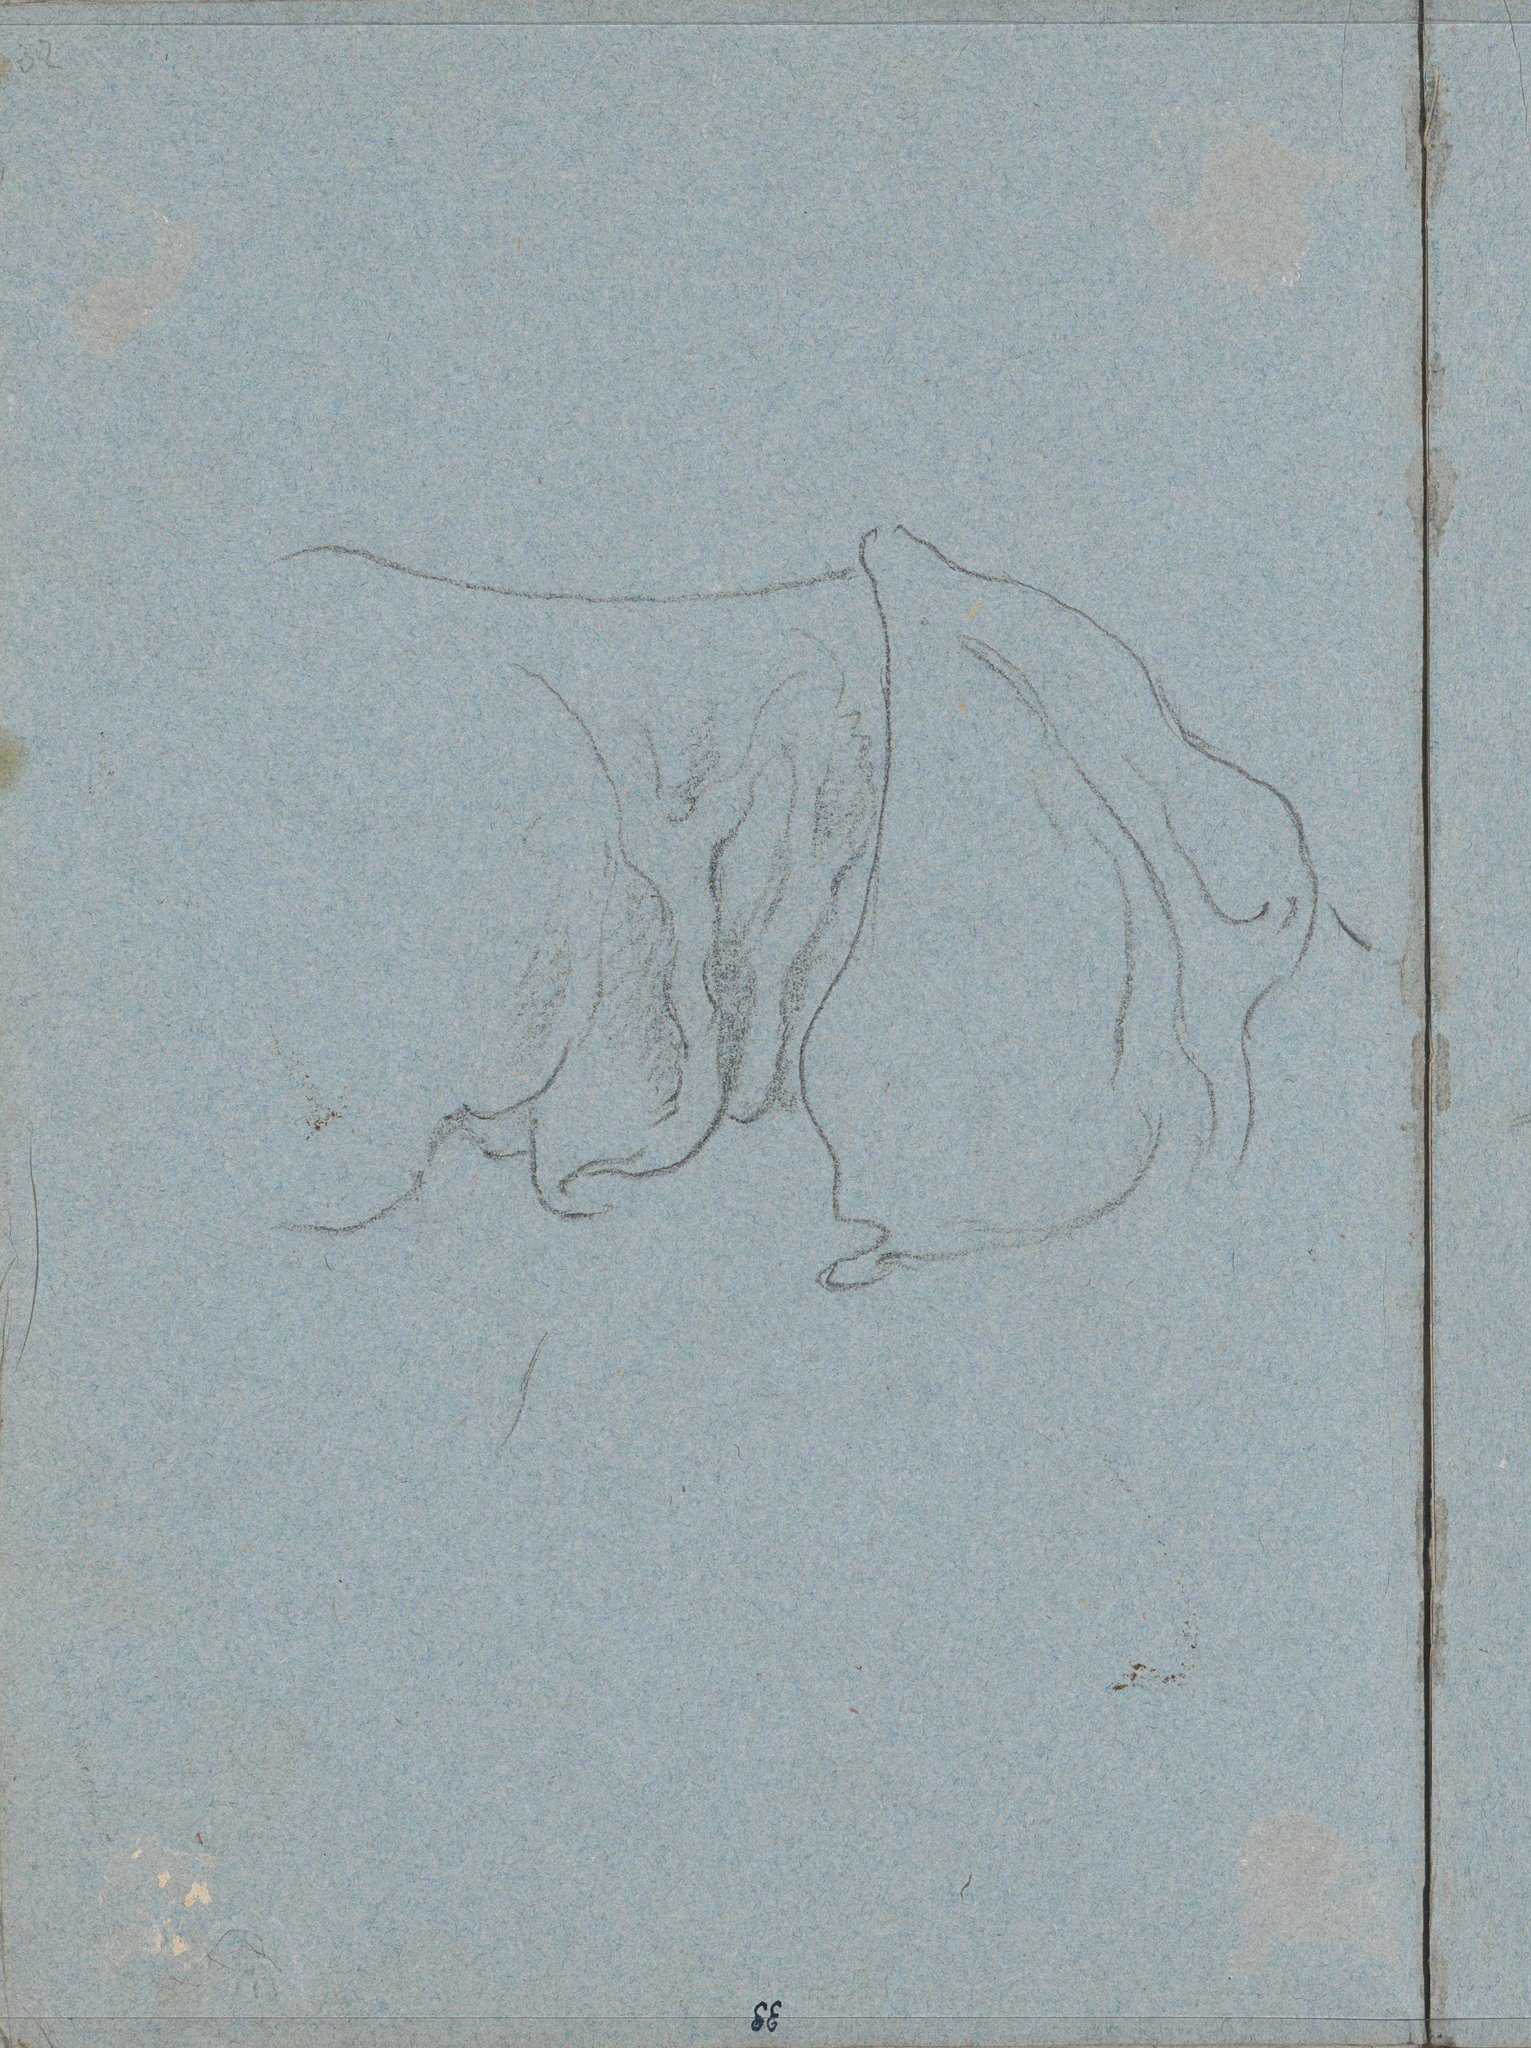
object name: sketchbook leaf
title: Huid van neushoorn Clara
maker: lorenzo baldissera tiepolo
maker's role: draughtsman, print maker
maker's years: 1736-1776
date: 1751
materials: chalk, paper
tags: hoofed animals: rhinoceros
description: Studie naar de neushoorn Clara, die vanaf 1746 een rondreis door Europa maakte (zie documentatie).